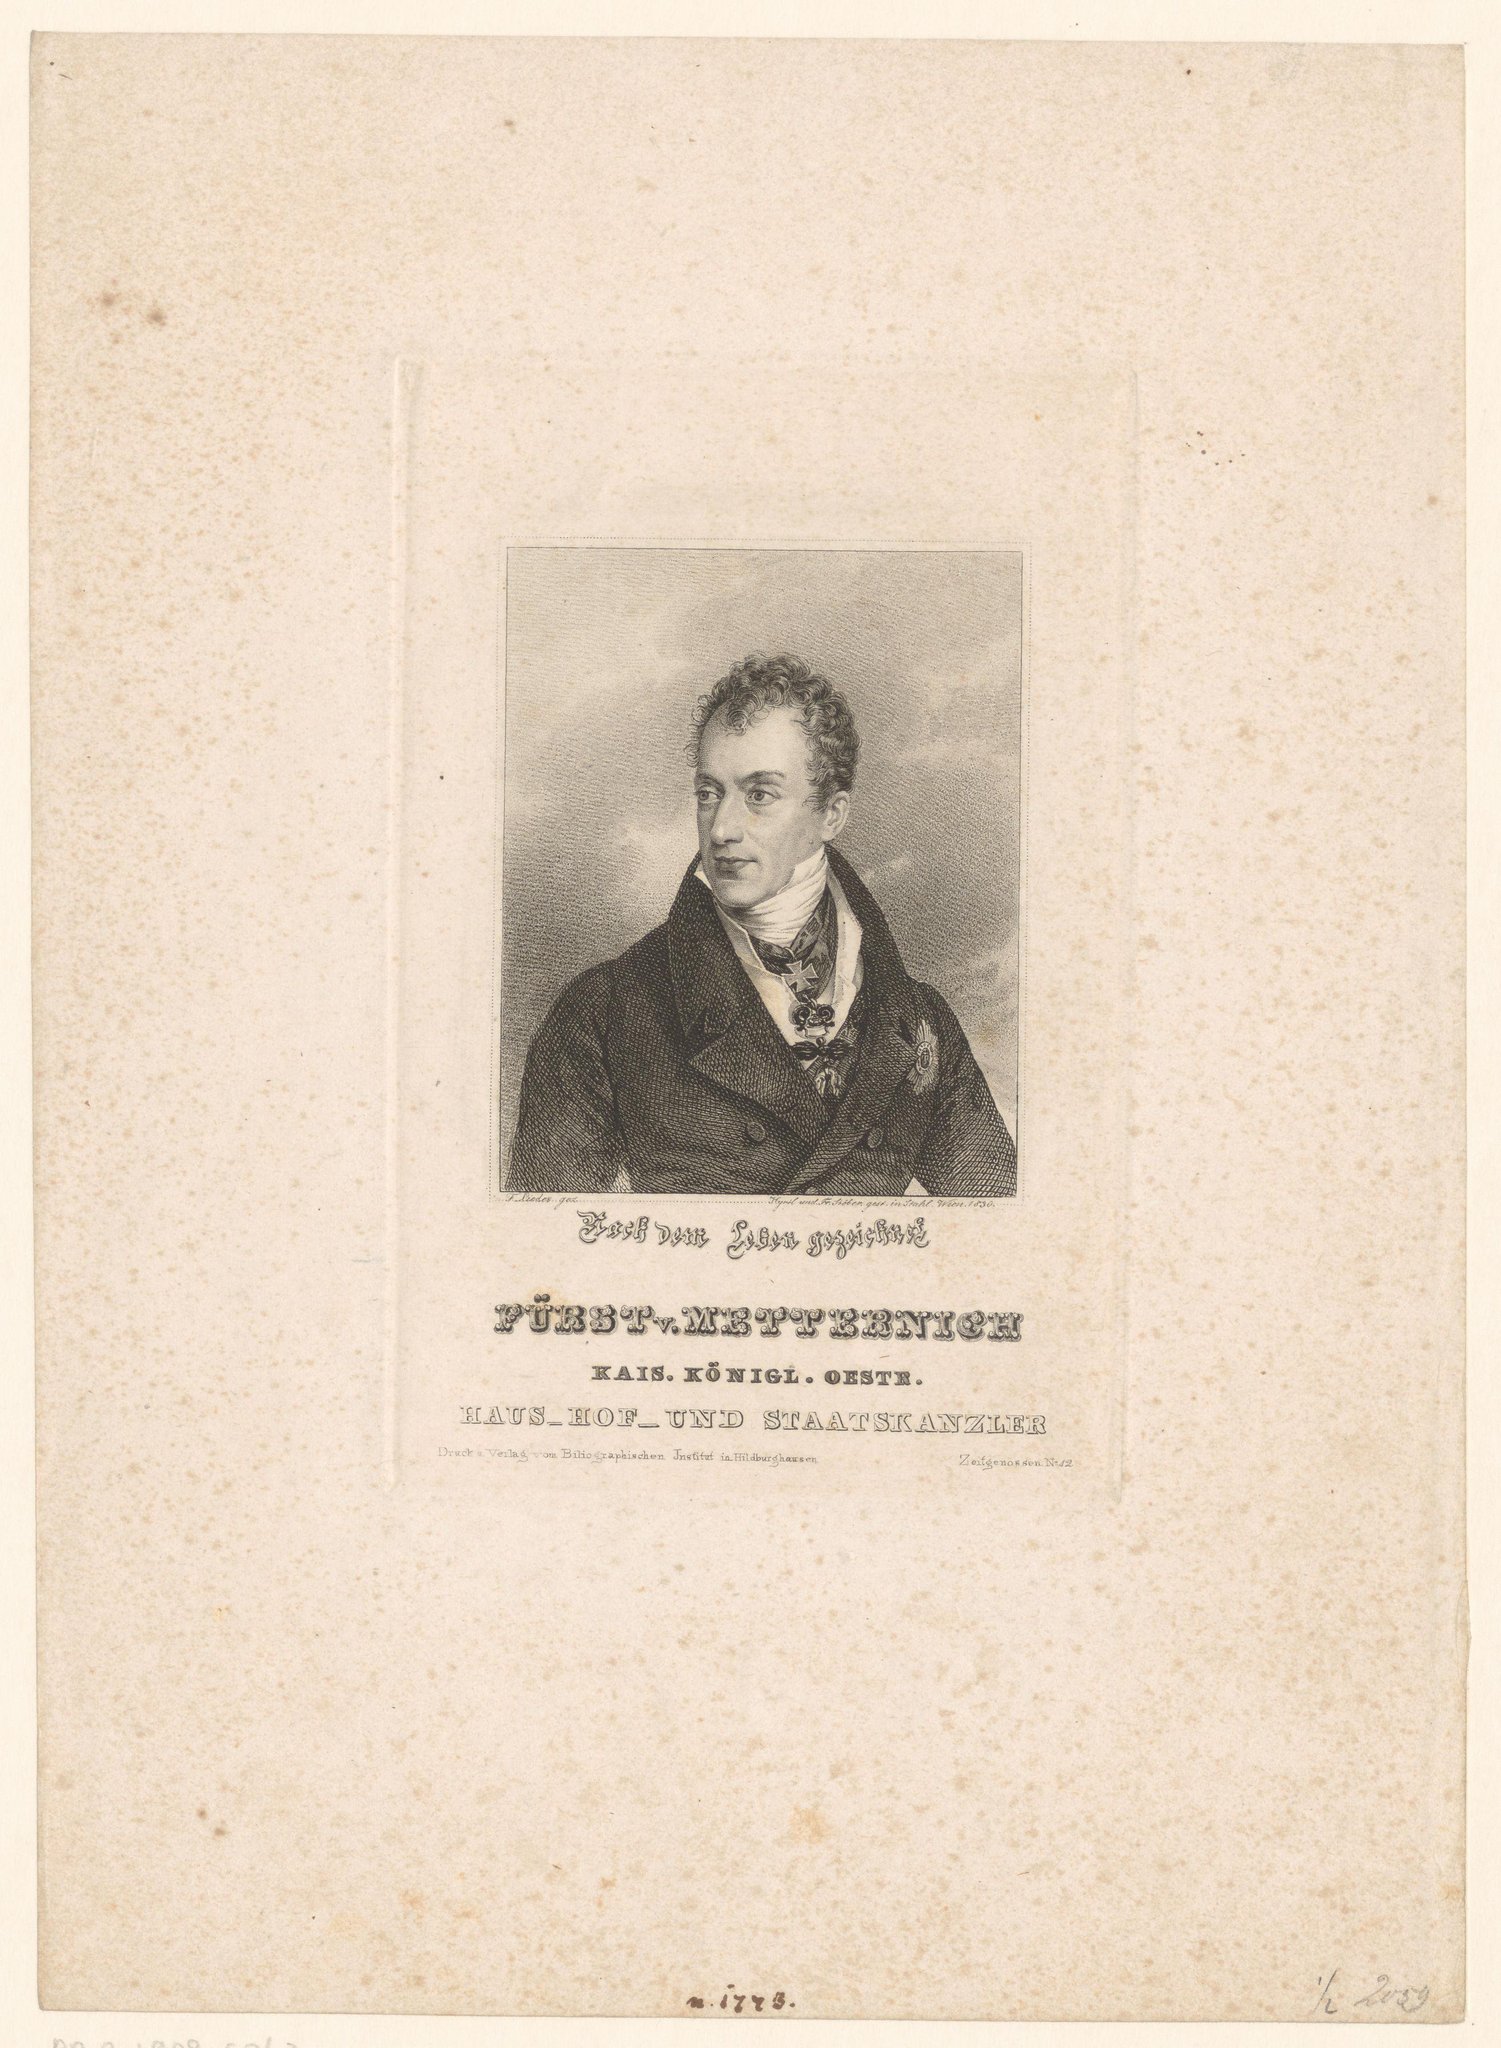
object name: print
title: Zeitgenossen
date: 1829-1840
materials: paper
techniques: etching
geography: hildburghausen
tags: historical persons, politician, e.g. party leader, ambassador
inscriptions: collector's mark: Lugt 2228, annotation: ‘n.irrb’